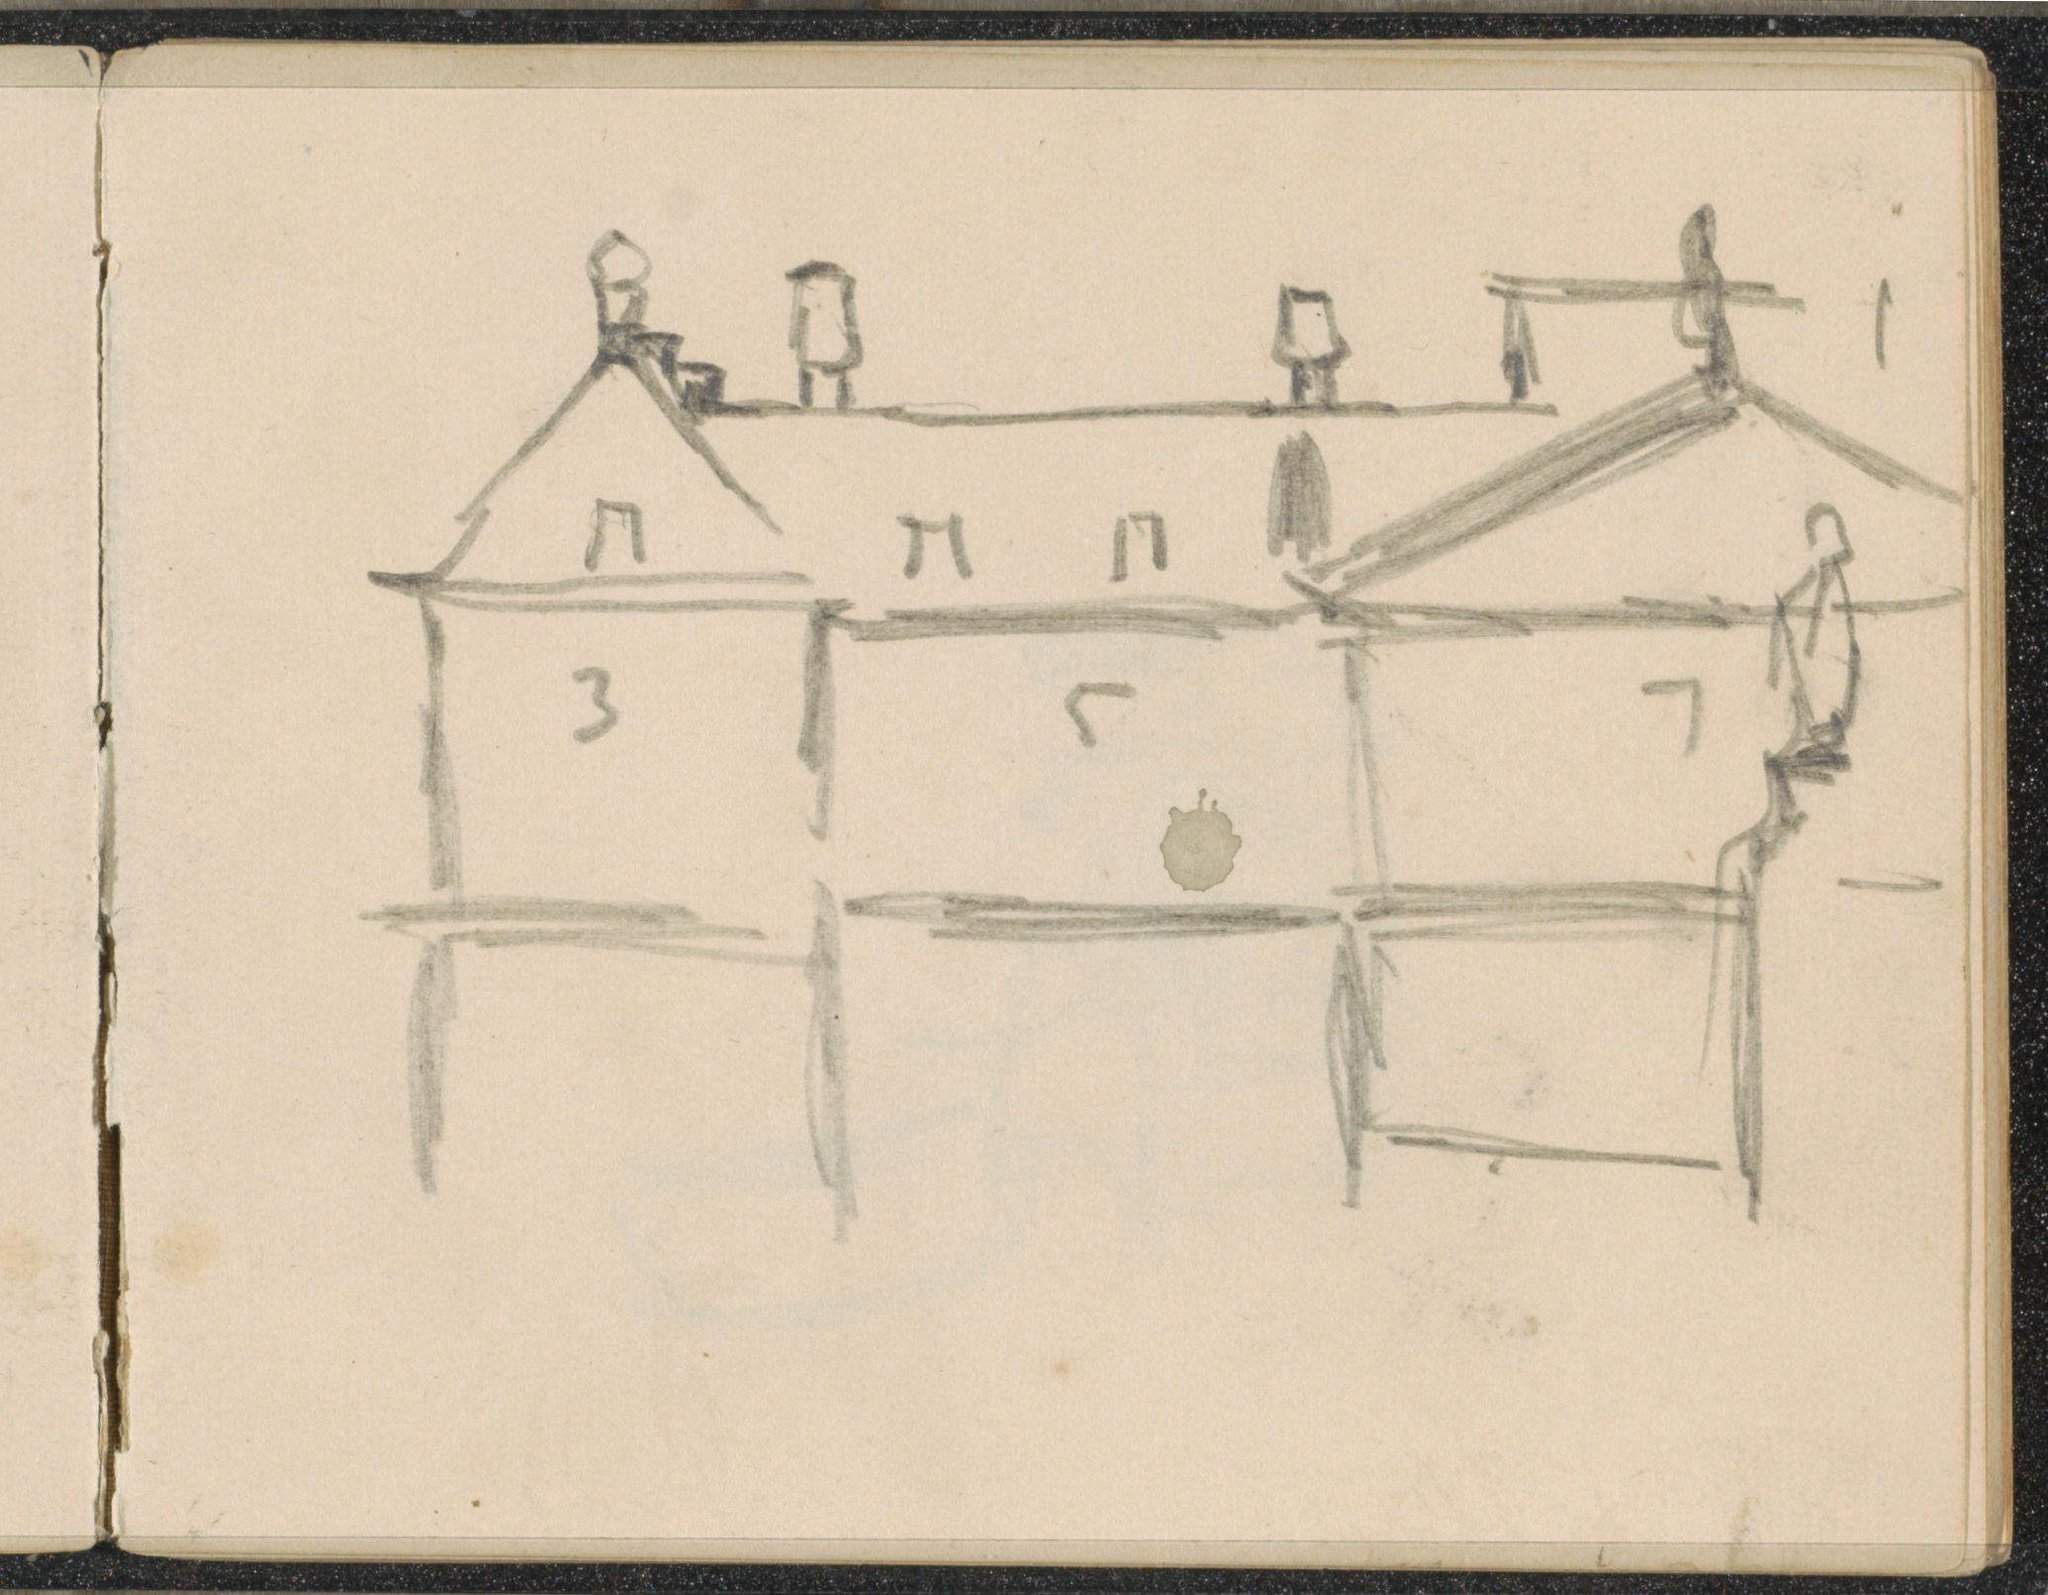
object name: sketchbook leaf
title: Voorgevel van het Koninklijk Paleis te Amsterdam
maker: george hendrik breitner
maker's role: draughtsman, painter, print maker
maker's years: 1857-1923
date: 1886-1903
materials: paper, pencil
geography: amsterdam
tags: palace, front façade, royal palace of amsterdam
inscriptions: annotation: ‘3 5 7’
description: Gezien vanaf de Dam. Pagina 14 uit een schetsboek met 32 bladen.